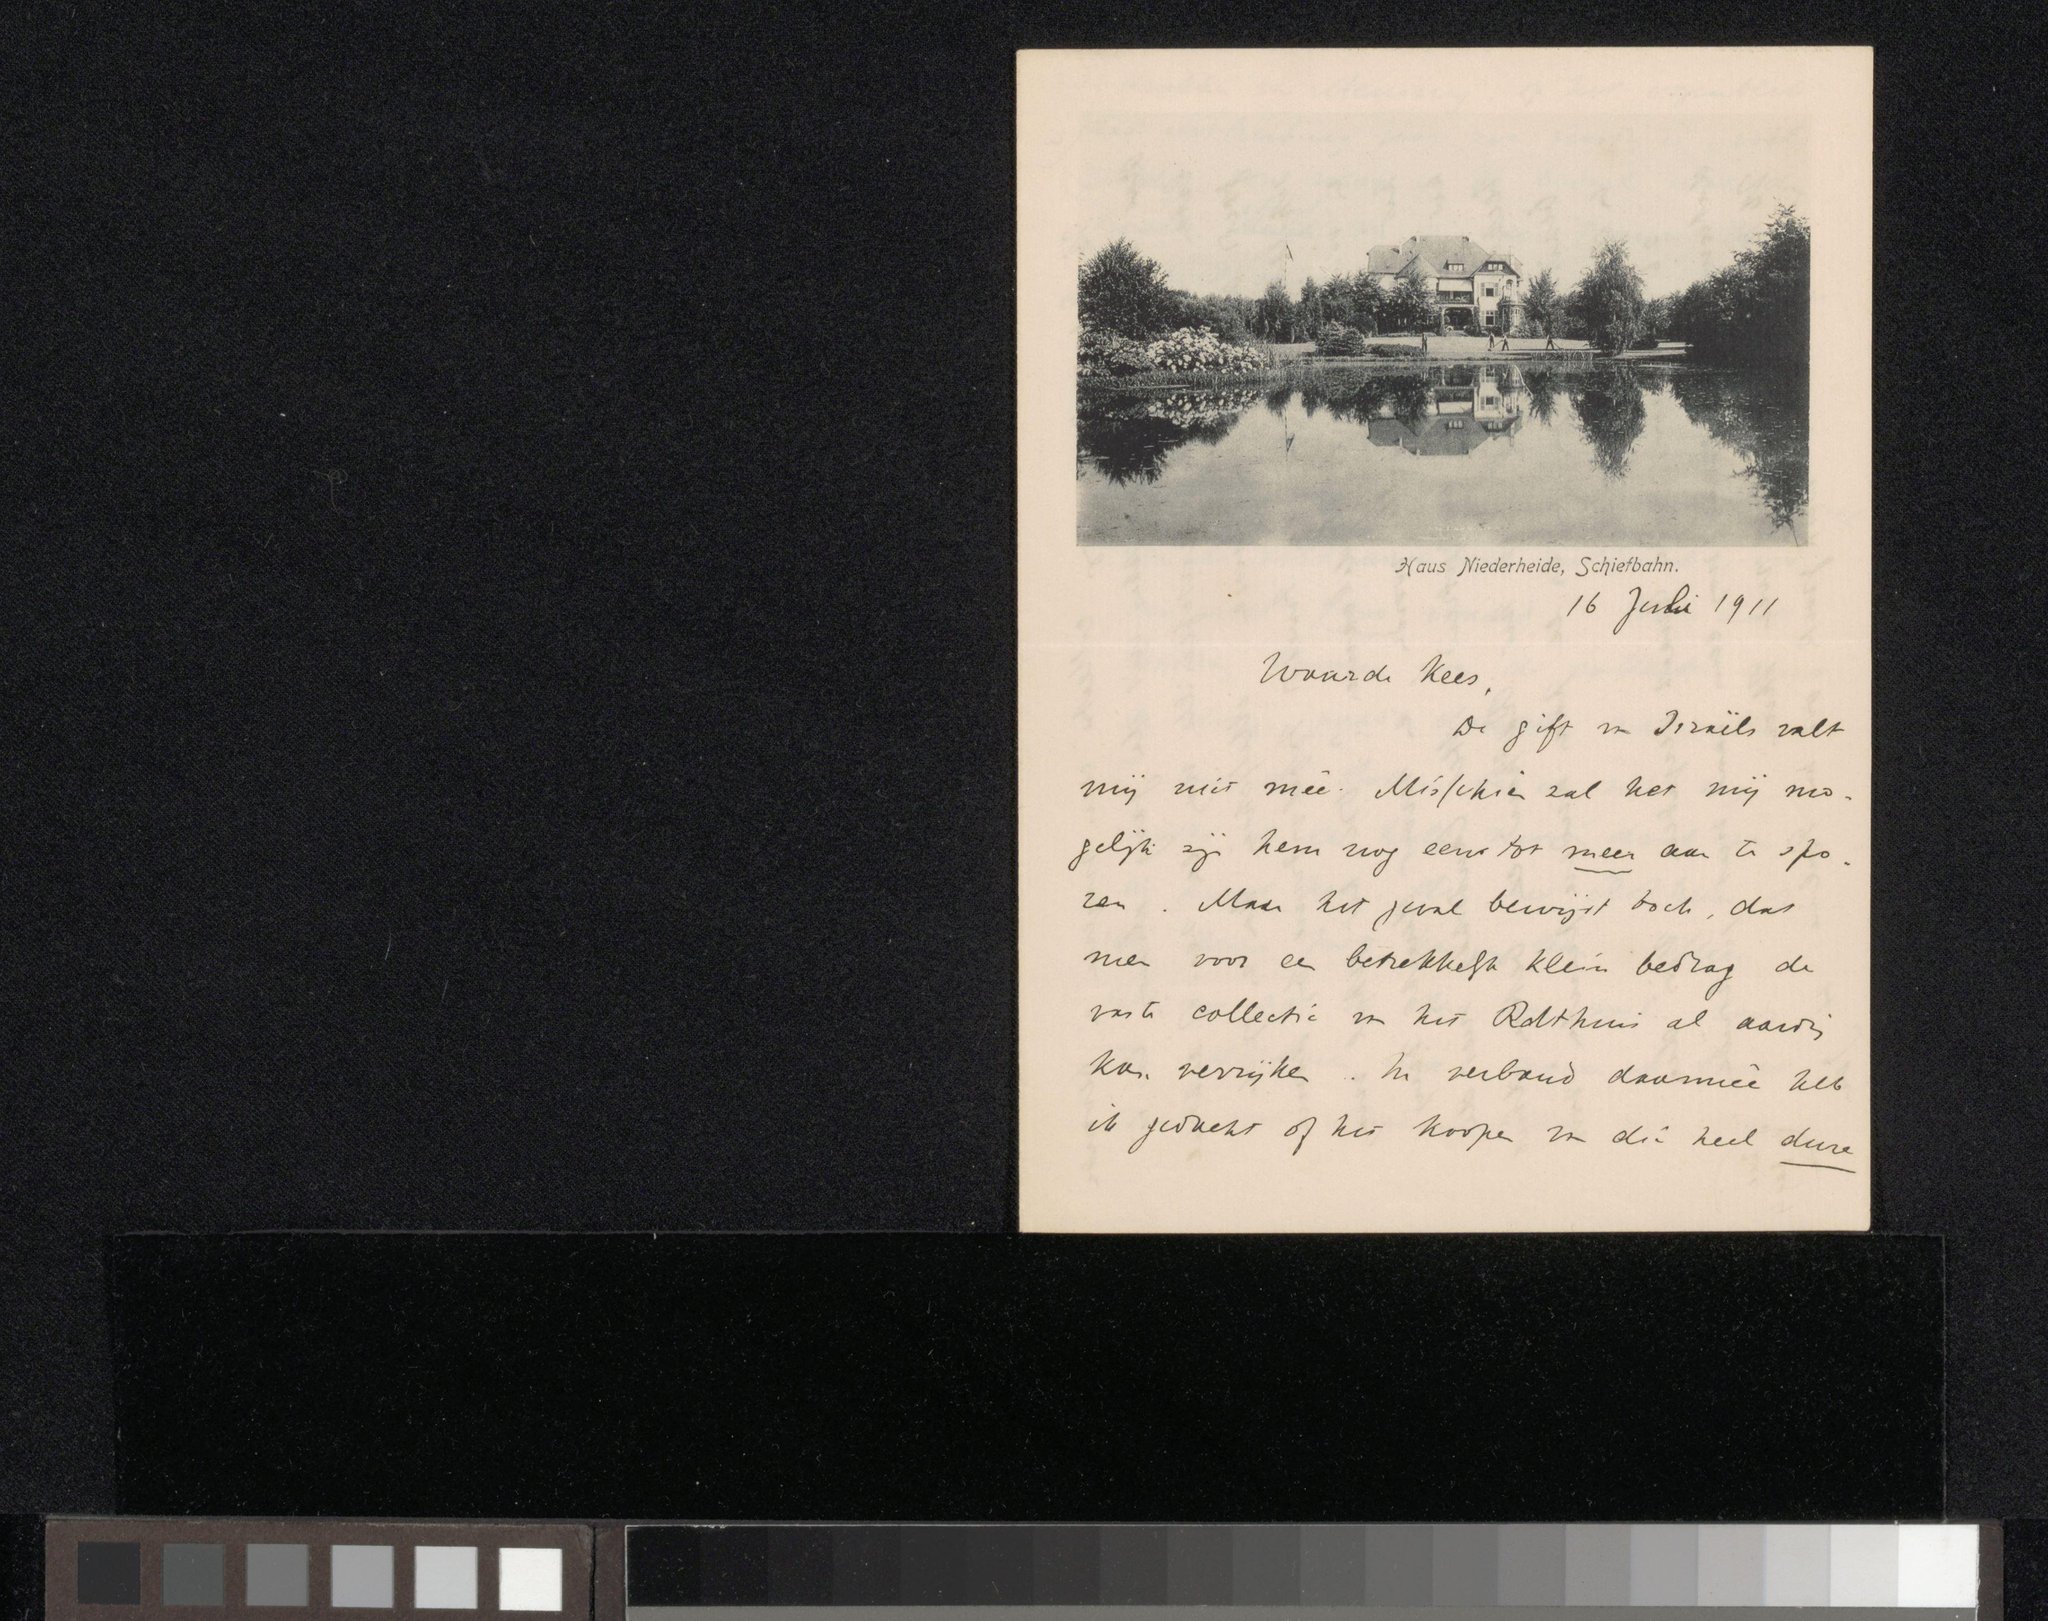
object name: letter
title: Brief aan Cornelis Gerdus 't Hooft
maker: jan veth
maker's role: designer, draughtsman, painter, print maker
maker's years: 1864-1925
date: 1911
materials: ink, paper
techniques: pen, printing, writing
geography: schiefbahn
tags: the hague, jozef israëls, antonius wilhelmus mari mensing, hendrick peter godfried quack, dordrecht, painter, draughtsman, cornelis gerardus 't hooft, the graphic arts, exhibition ~ art, art collecting, money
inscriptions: collector's mark: ‘RPK’